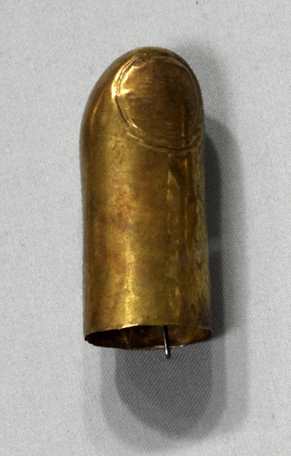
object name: toe stall, group 2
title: Toe stall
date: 1479-1425 BCE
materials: gold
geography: egypt